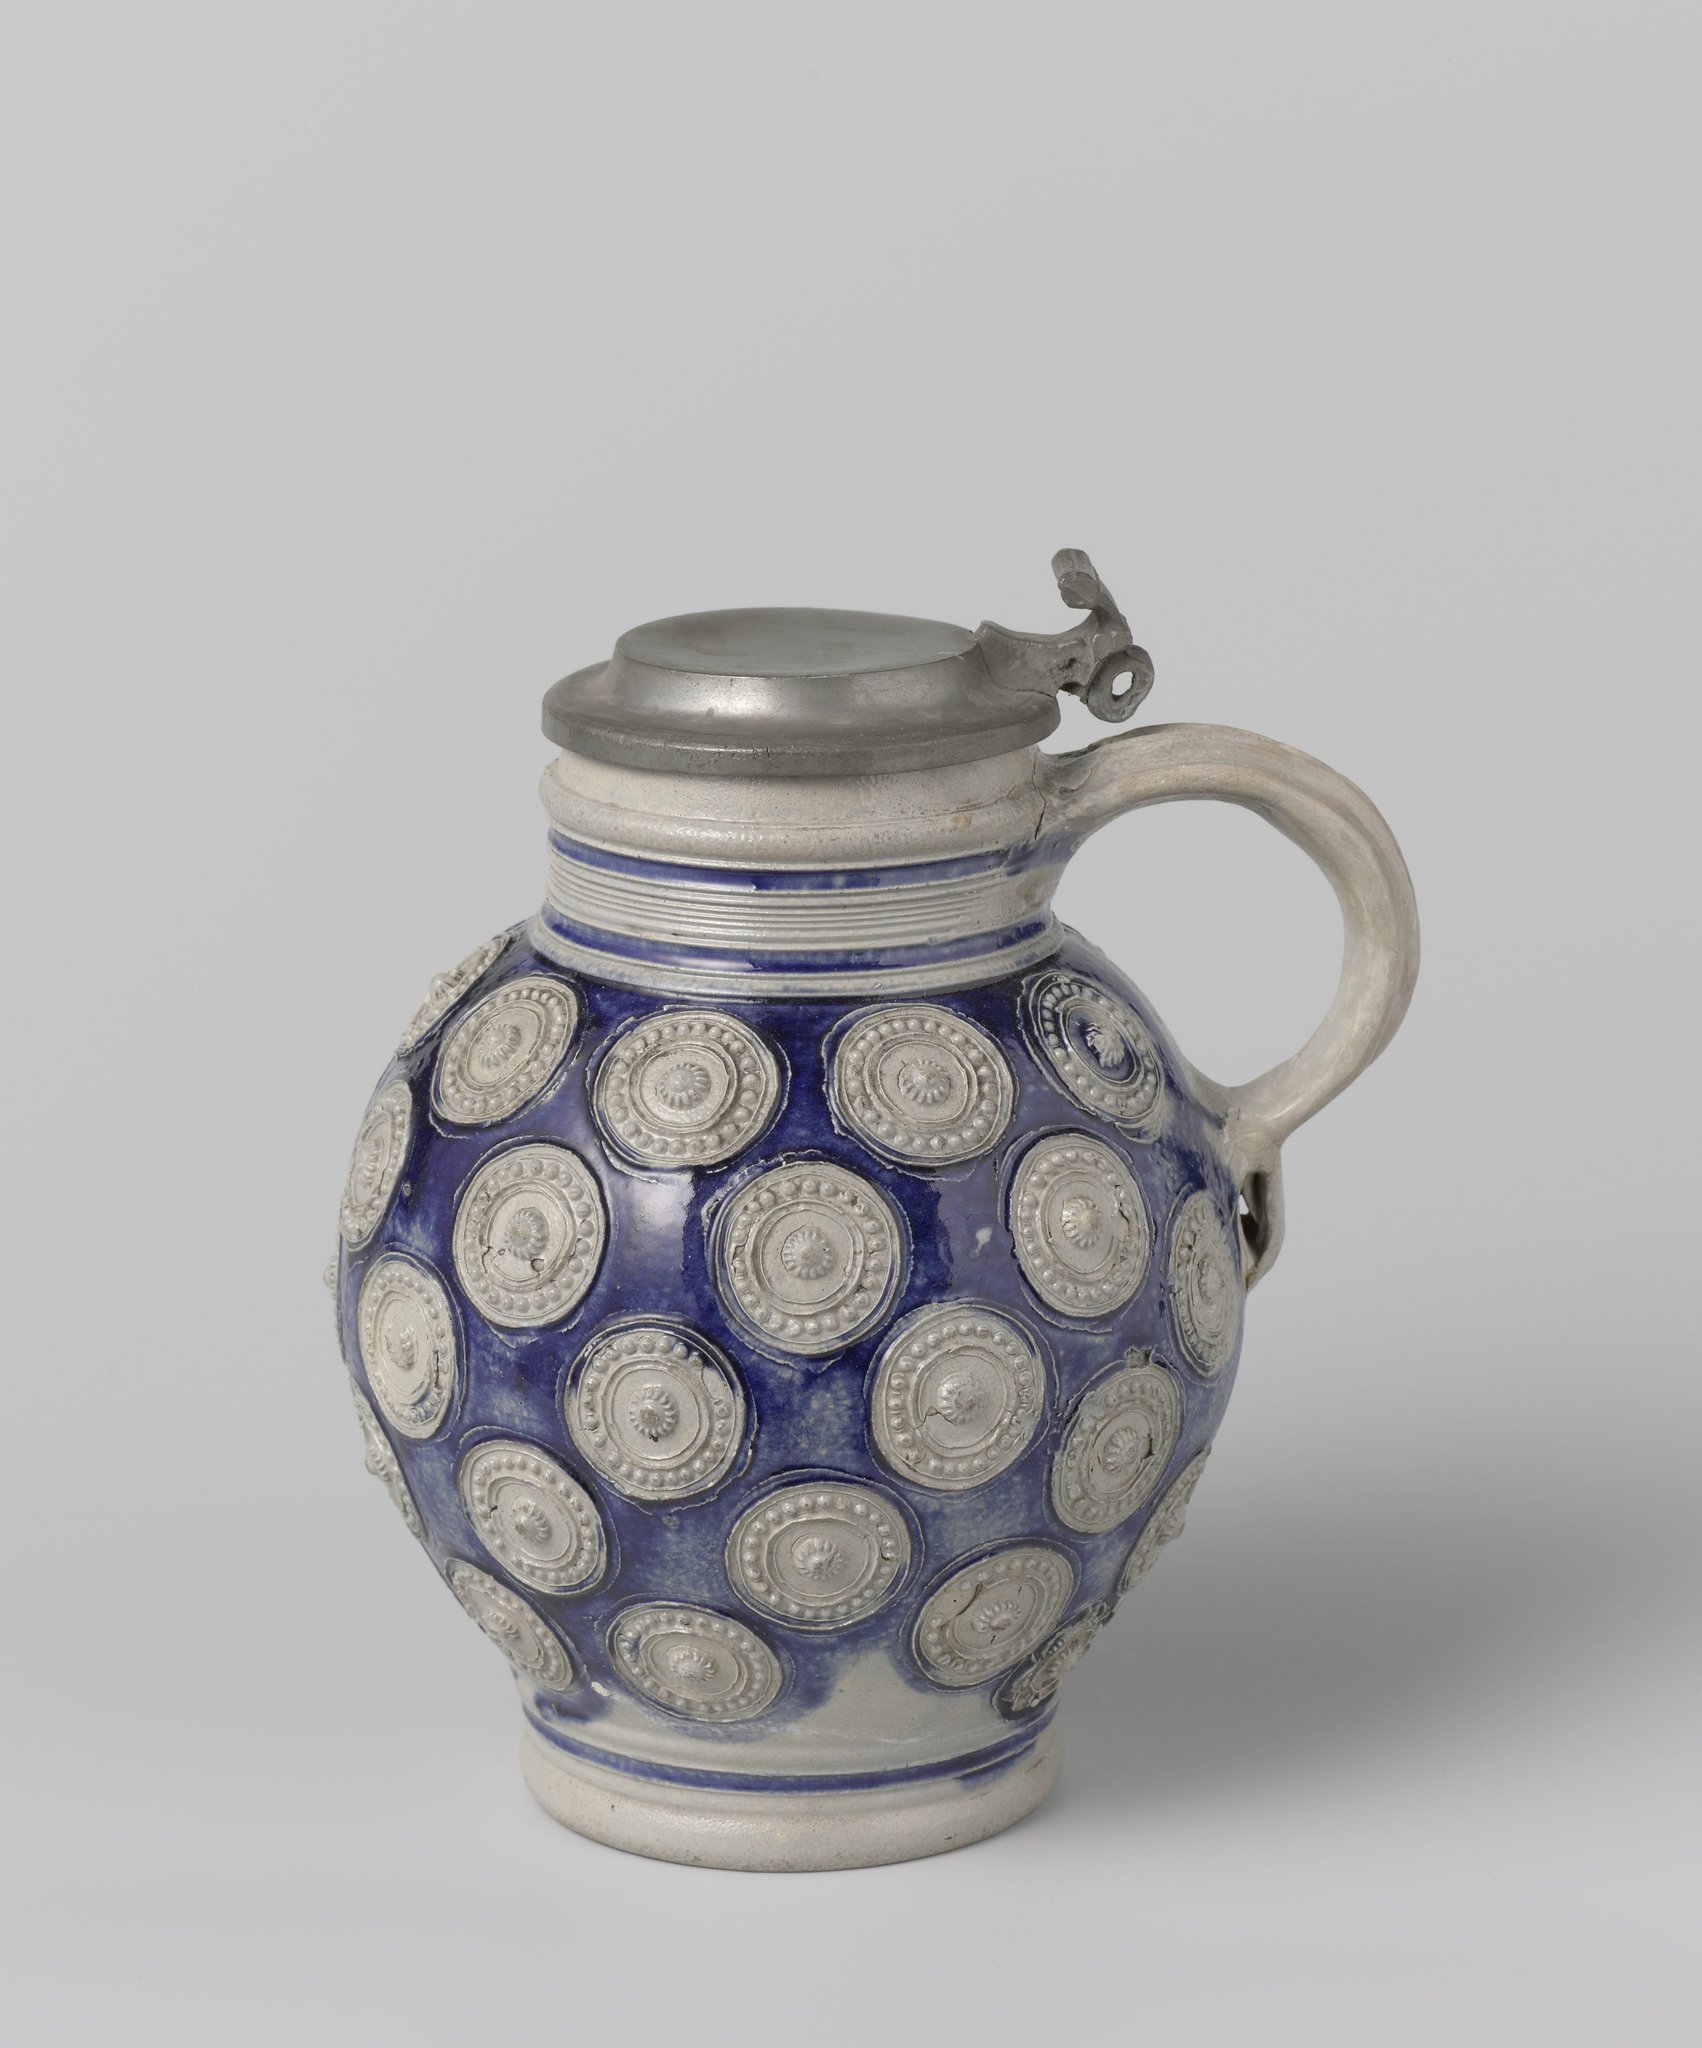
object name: jug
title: Jug with medallions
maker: Anonymous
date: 1650-1724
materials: cobalt, glaze, stoneware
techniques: firing, forming, relief, turning, vitrification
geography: westerwald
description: Kruik van steengoed op hoge voet met een bolvormig lichaam en korte, wijde nek. Het C-vormige oor is bevestigd aan de nek en de schouder. Profielen op de nek en voet. Gedeeltelijk op het glazuur bedekt met kobaltblauw. De kruik is versierd met een reliëfdecoratie waarbij de buik grotendeels is bedekt met gedrukte, opgelegde medaillons met een bloemrozet tegen een blauwe achtergrond. Blauwe lijnen op de nek en voet. Westerwald.